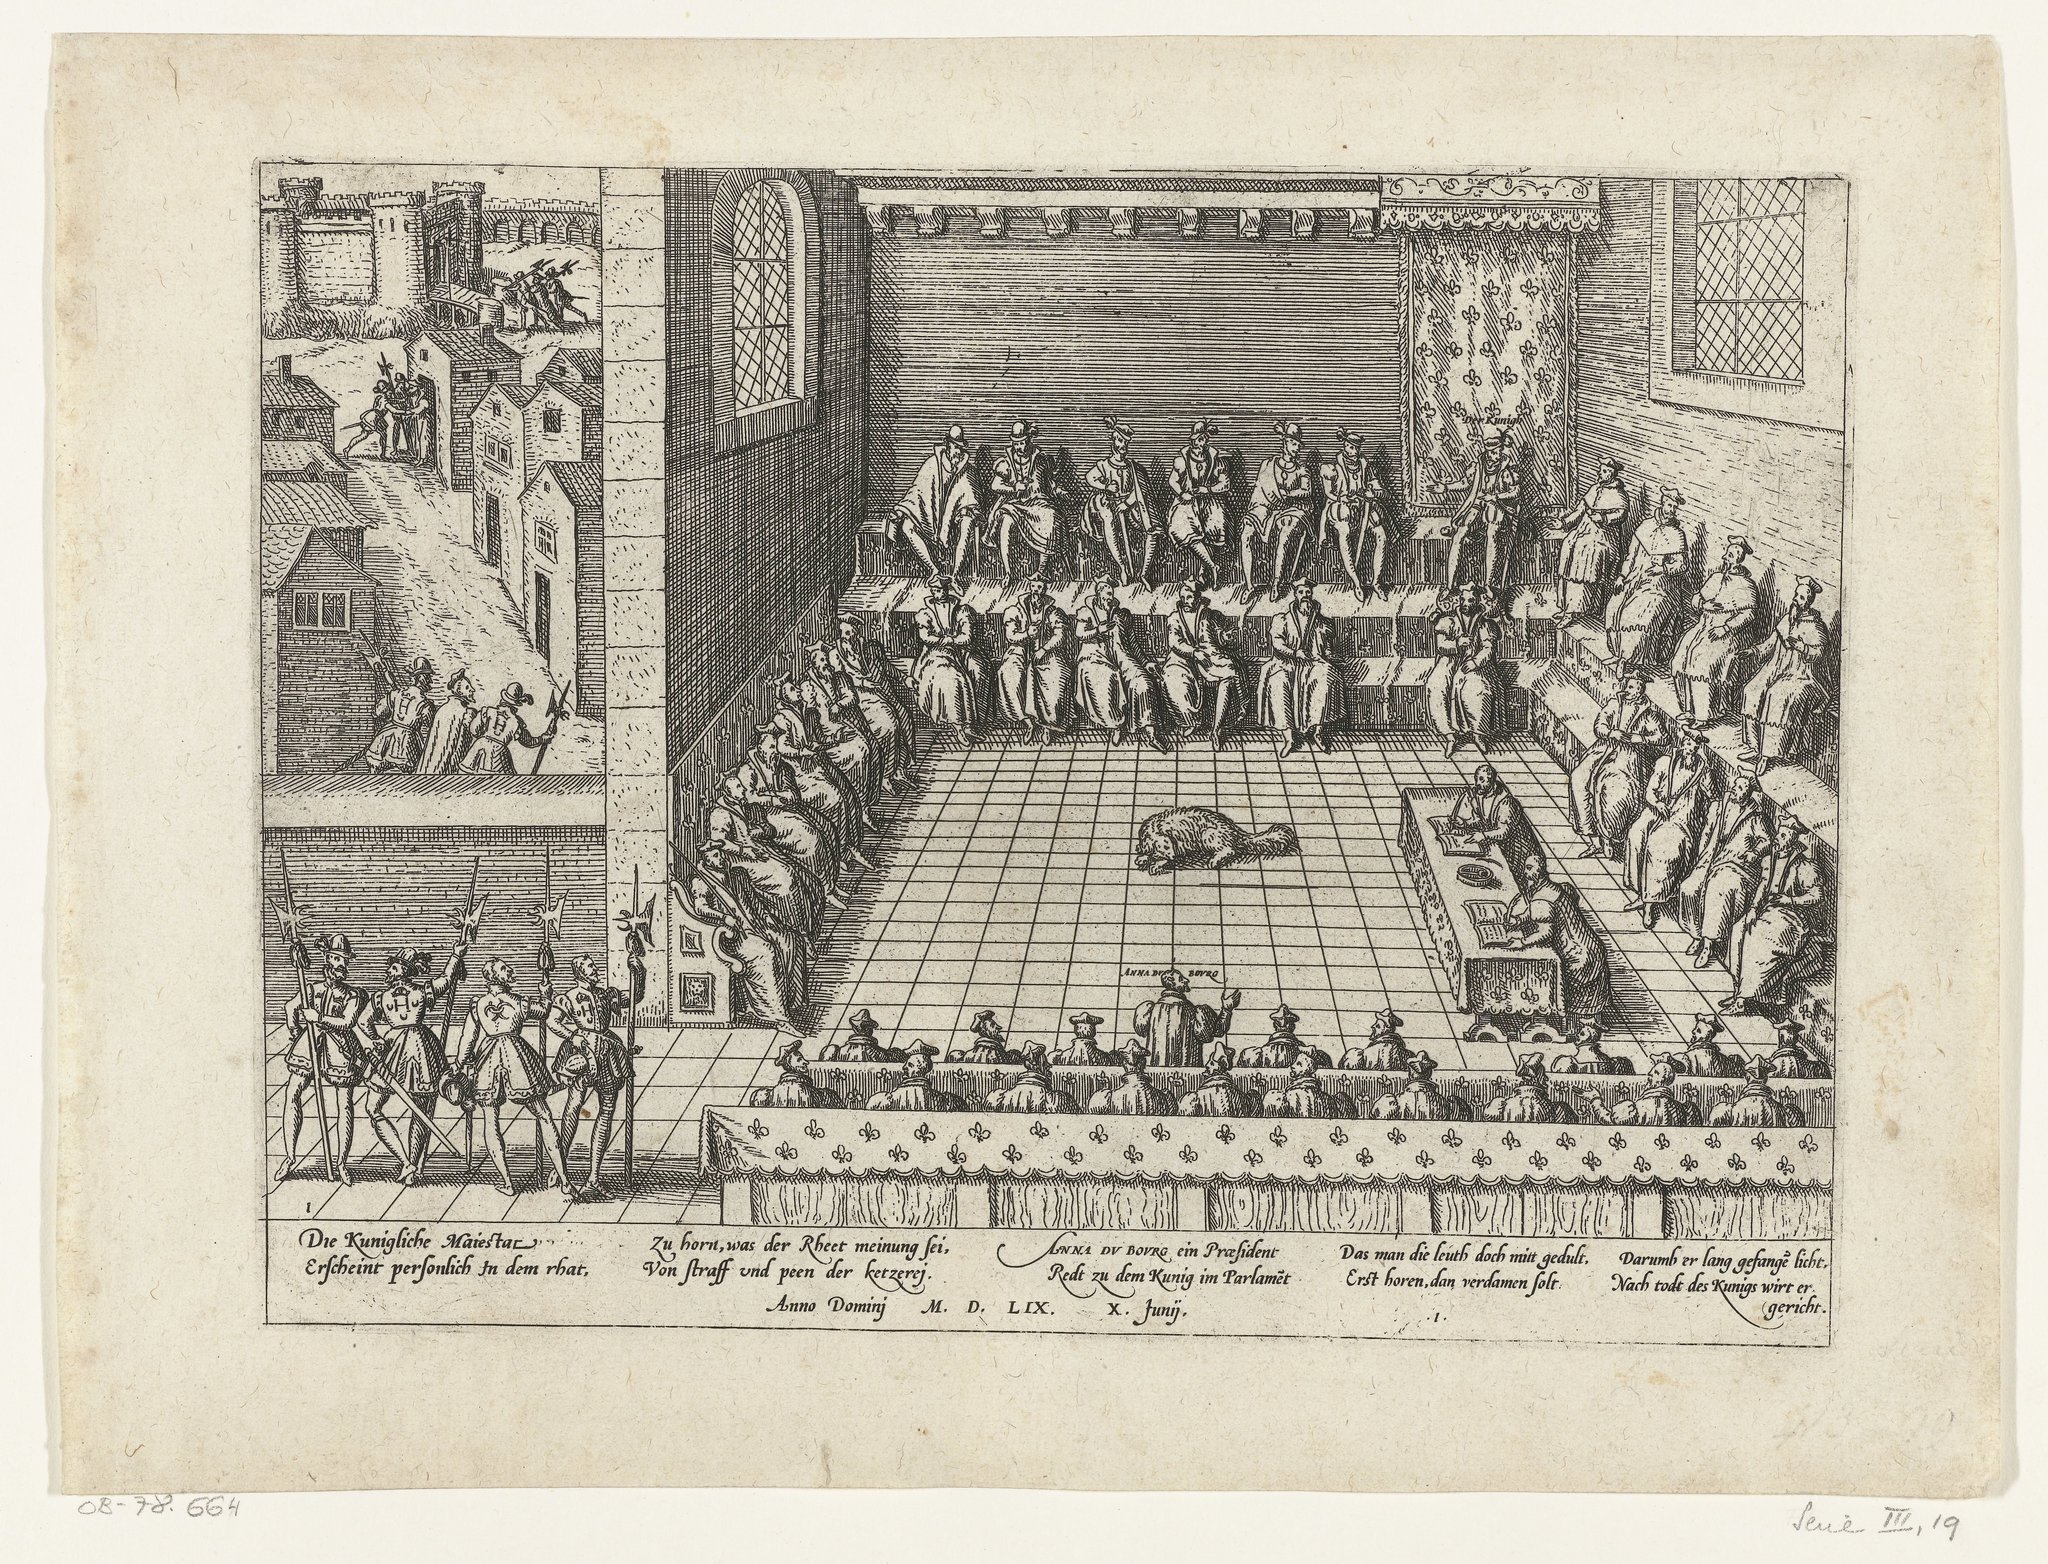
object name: print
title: Serie 3: Franse Godsdienstoorlogen, 1559-1573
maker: frans hogenberg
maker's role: print maker, publisher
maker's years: 1538-1590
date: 1565-1573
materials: paper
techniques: etching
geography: cologne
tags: paris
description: Gekopieerd naar de prent van J. Perrissin in: Jean Tortorel et Jacques Perrissin, Premier volume contenant quarante tableaux ou Histoires diverses qui sont memorables touchant les Guerres, Massacres et Troubles advenus en France en ces dernieres annees : le tout recueilly selon le tesmoignange de ceux qui y ont esté en personne et qui les ont veus : lesquels sont pourtraits à la vérité, Geneve ca. 1570. Bibliotheek Rijksmuseum: 329 A 2, pl. 2, gedateerd 1570.